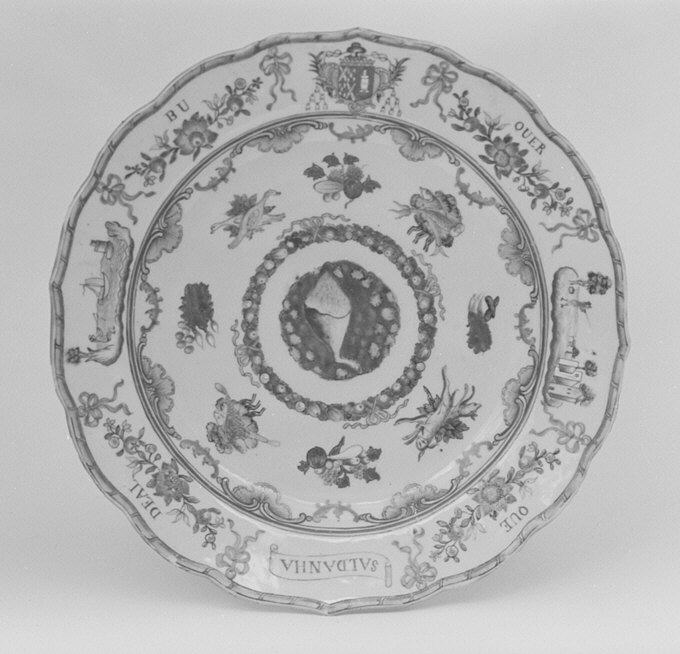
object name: plate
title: Plate (part of a service)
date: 1765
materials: hard paste porcelain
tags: birds,flowers,coat of arms